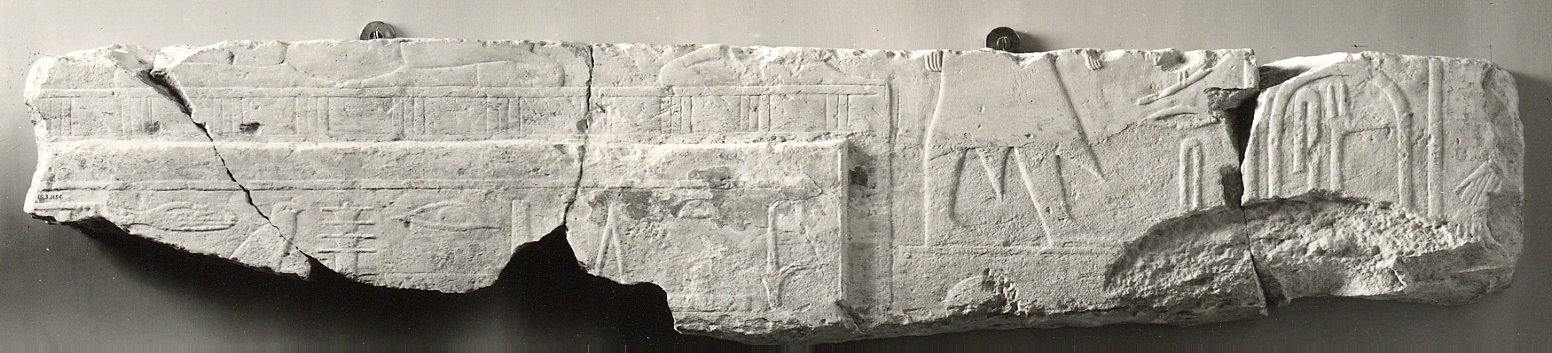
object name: relief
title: Relief fragment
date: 1981-1917 BCE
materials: limestone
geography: egypt